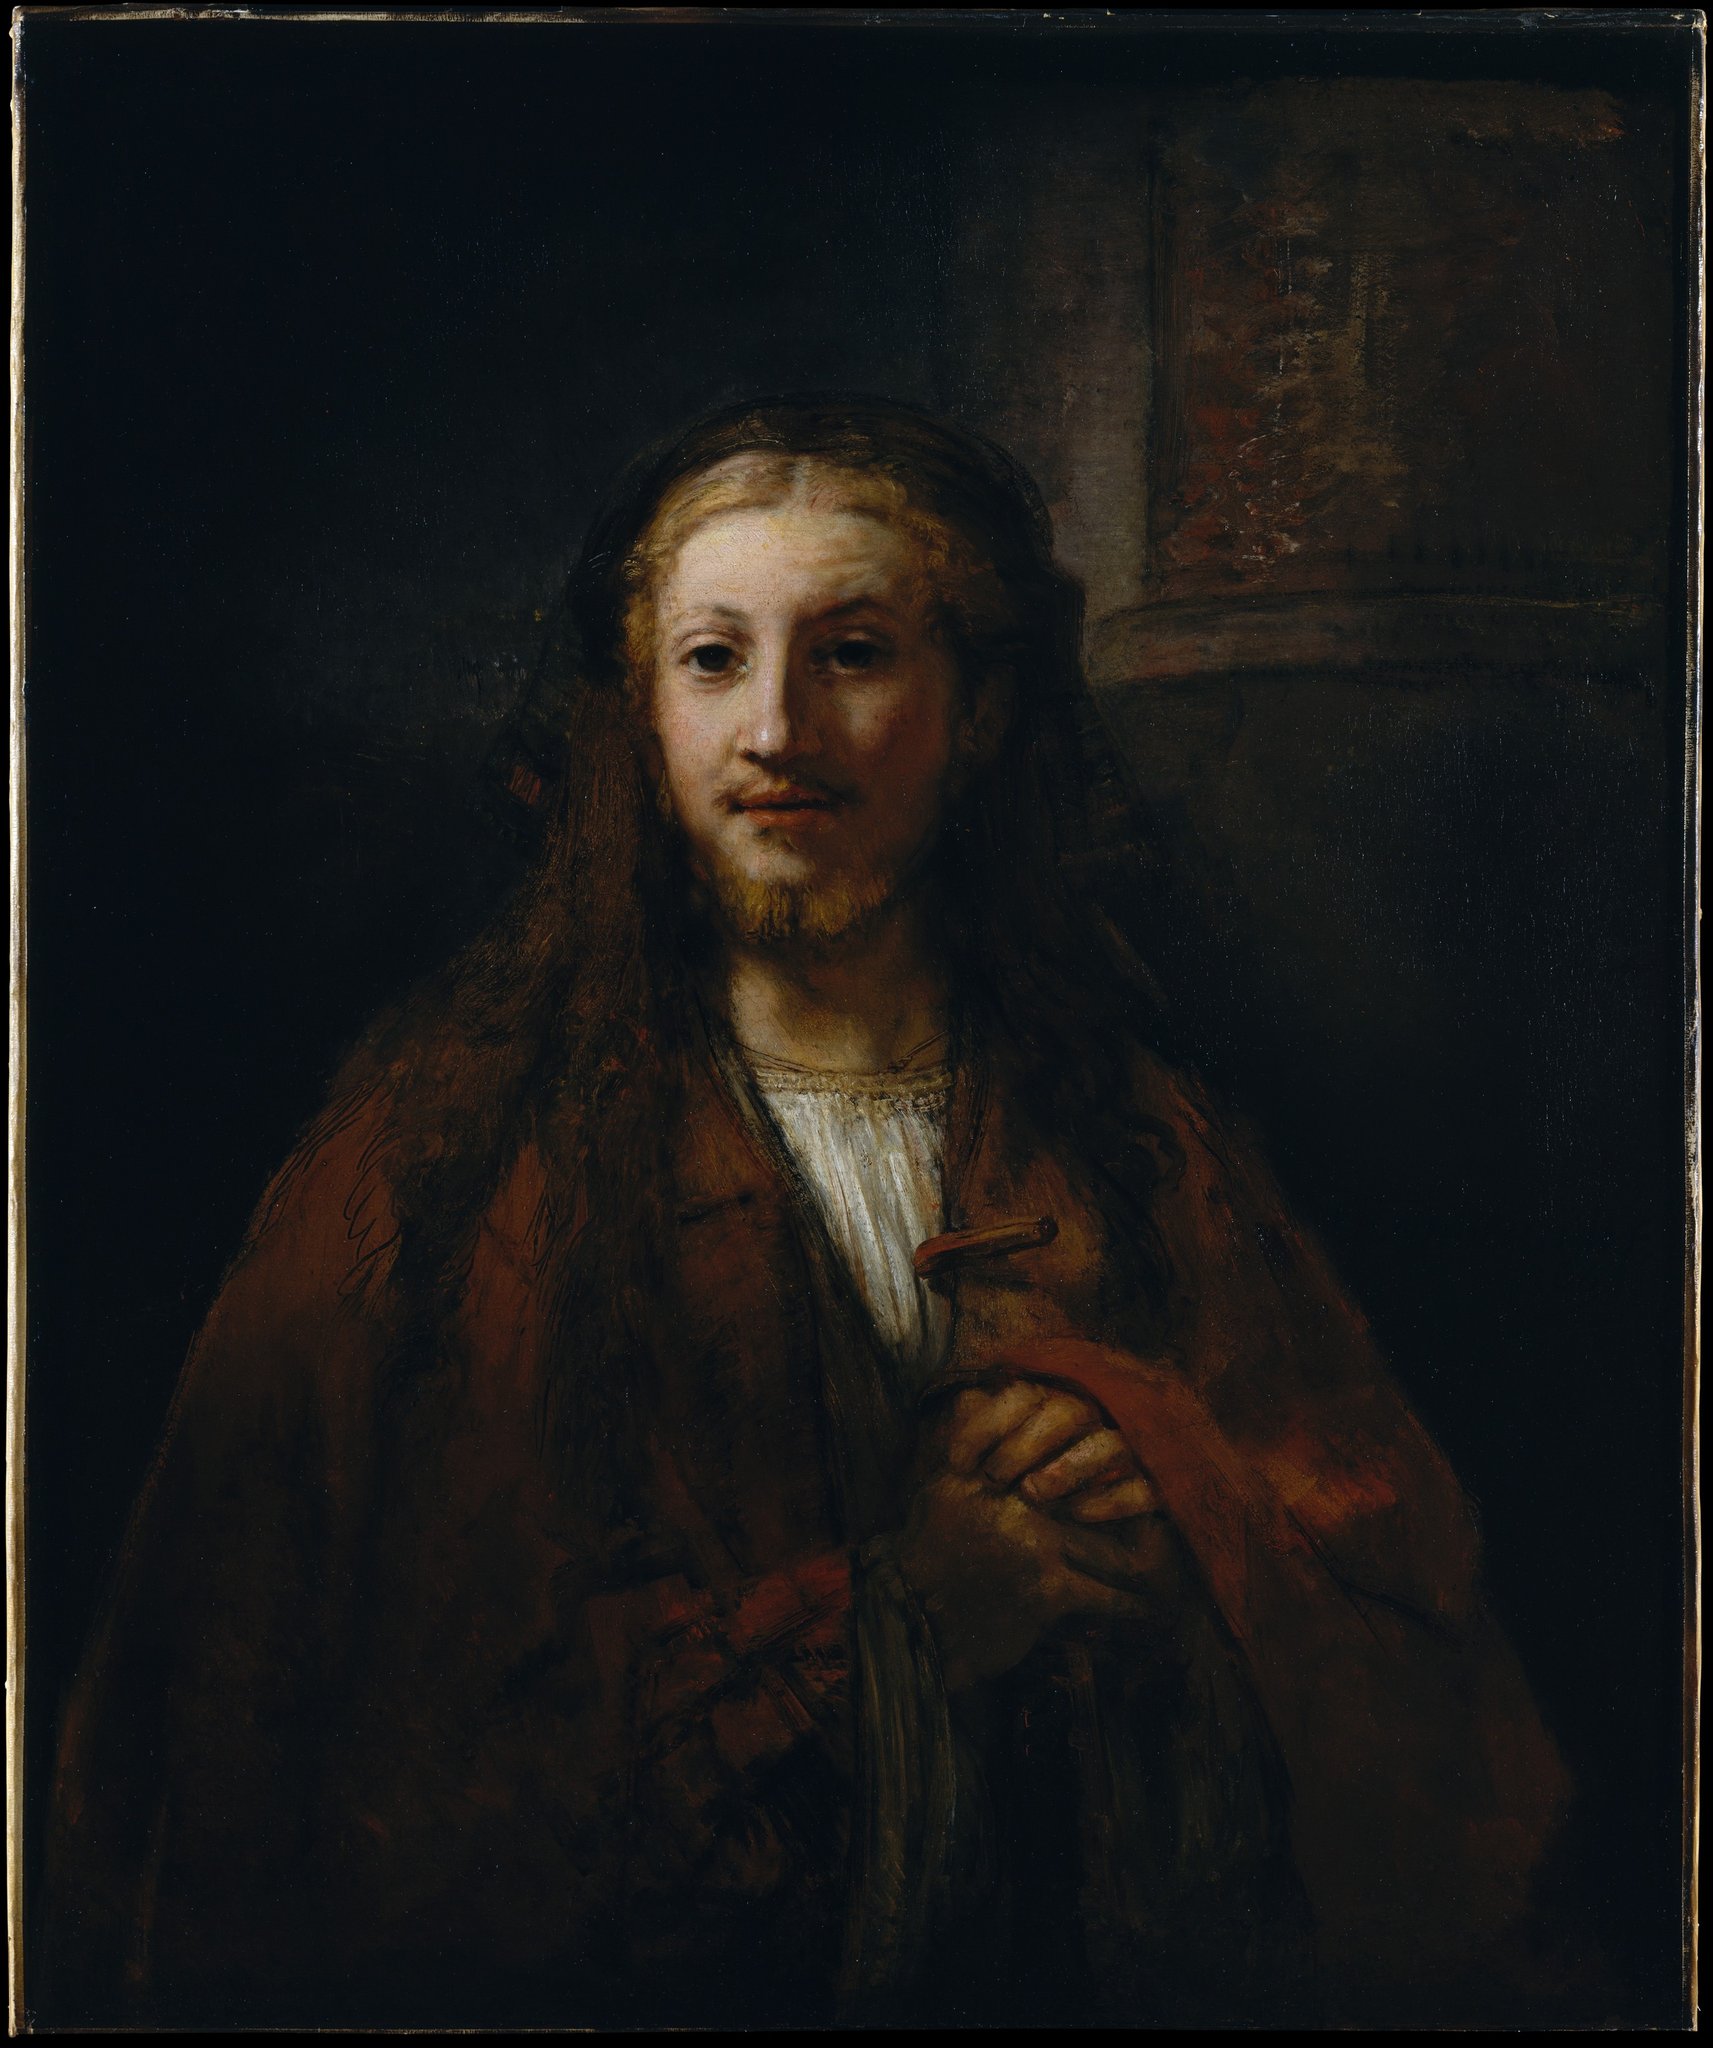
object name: painting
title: Christ with a Staff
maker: rembrandt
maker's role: artist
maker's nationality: dutch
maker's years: 1606-1669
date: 1650-1674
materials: canvas, oil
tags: christ